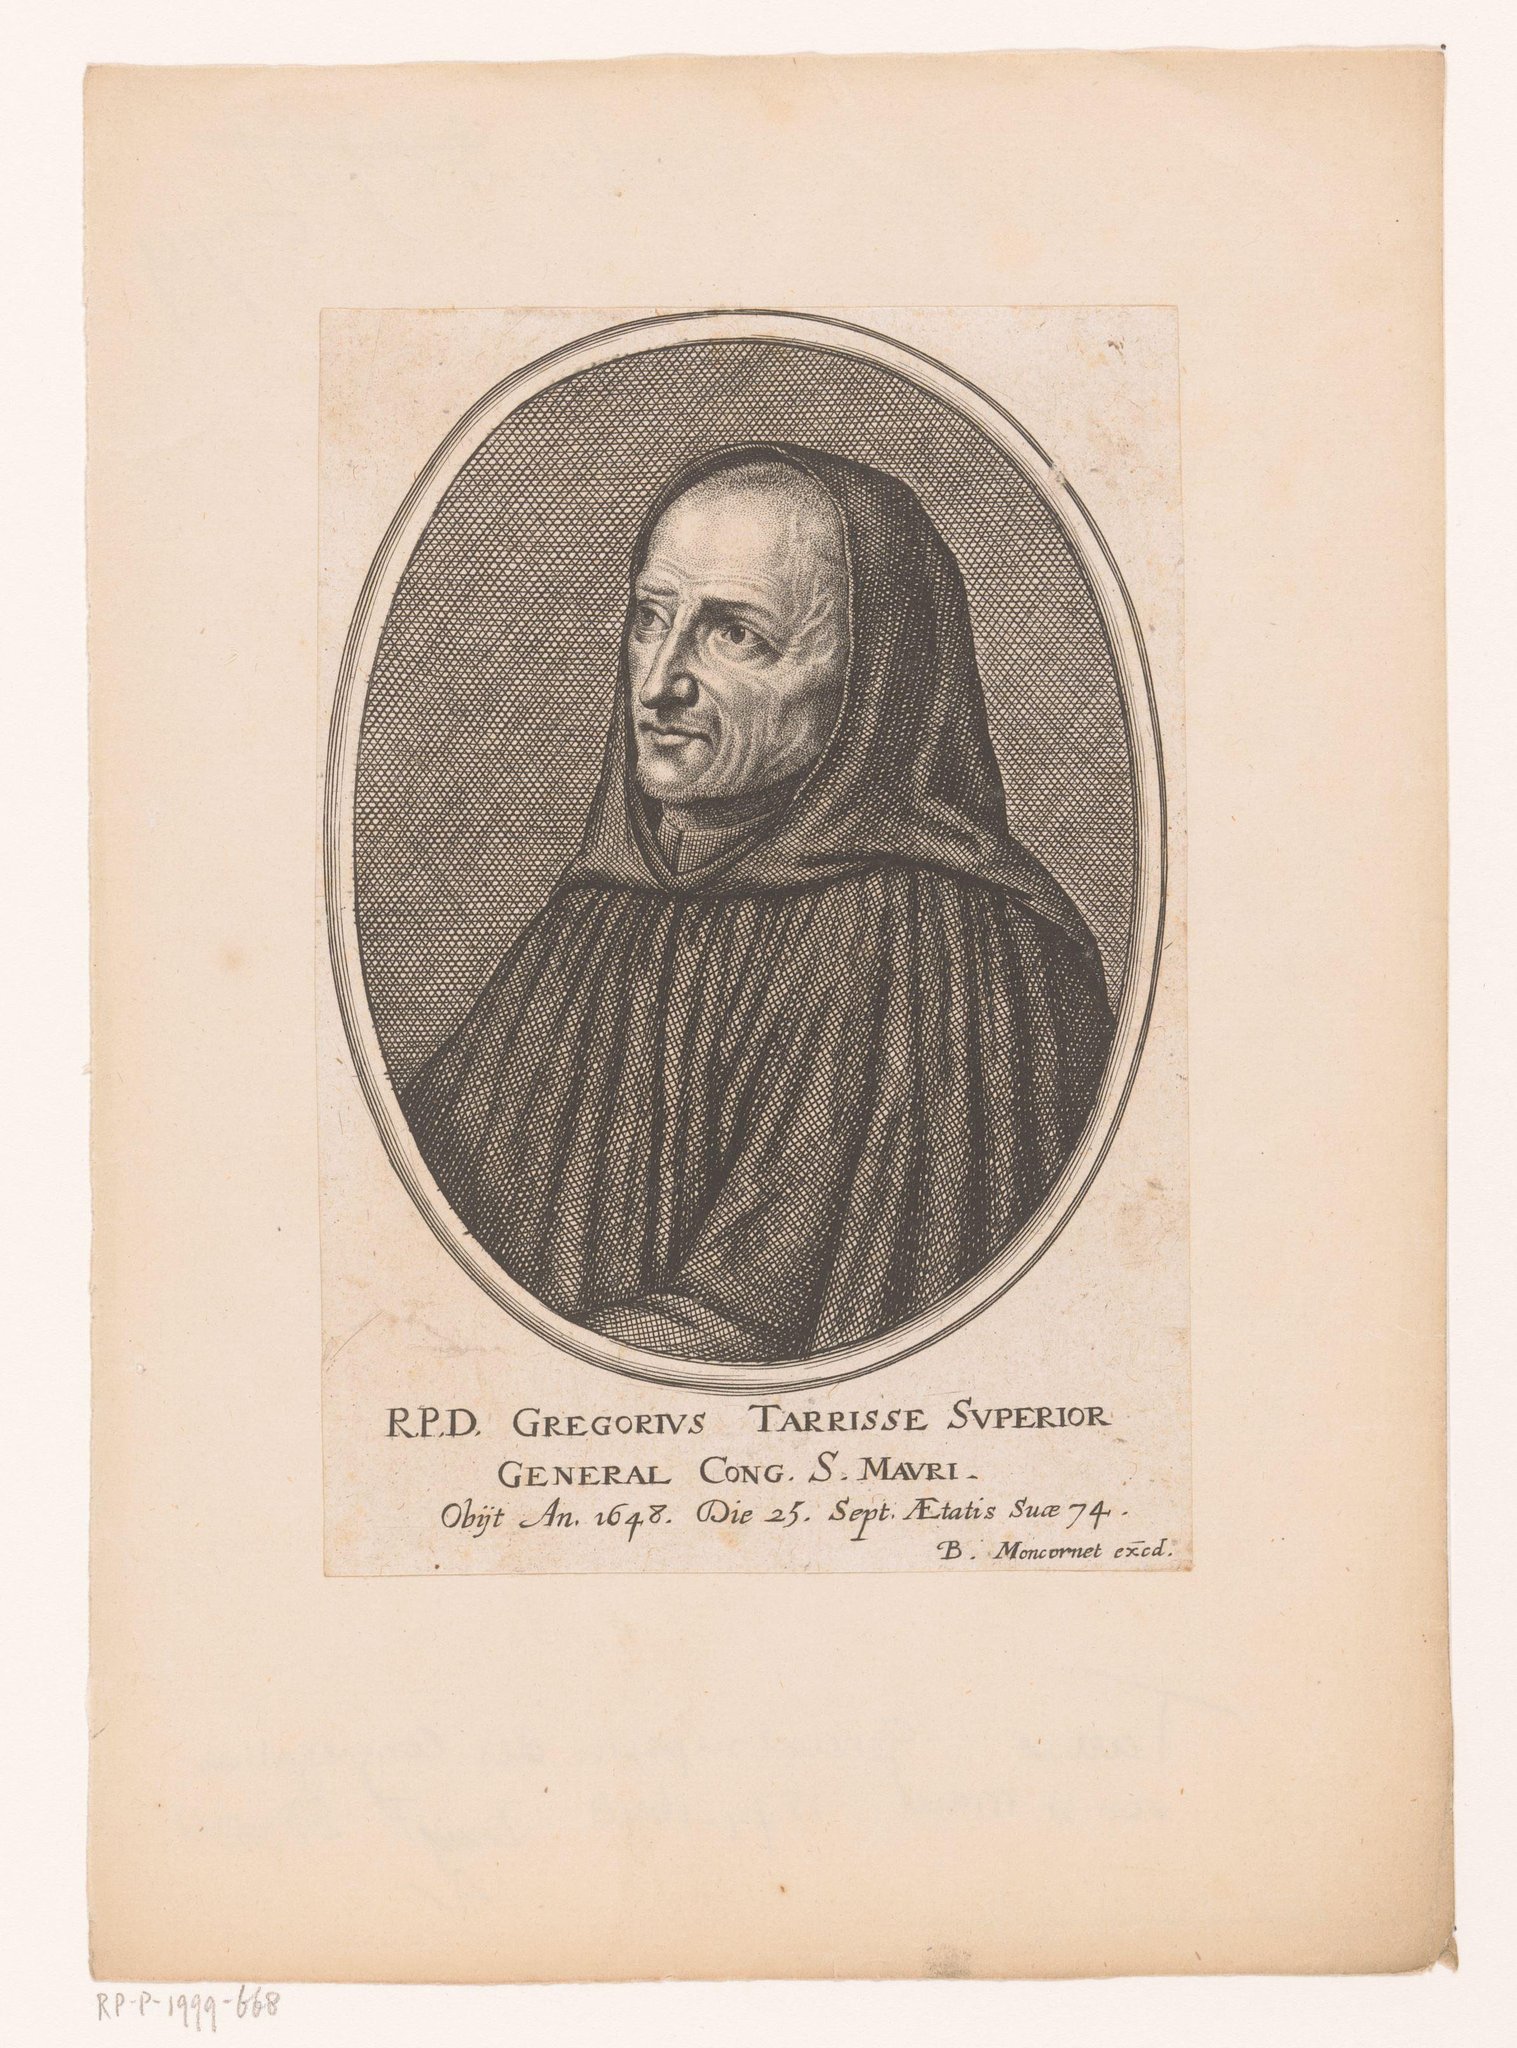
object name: print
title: Portret van Grégoire Tarrisse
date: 1648-1668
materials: paper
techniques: engraving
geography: paris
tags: historical persons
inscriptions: collector's mark: Lugt 2228